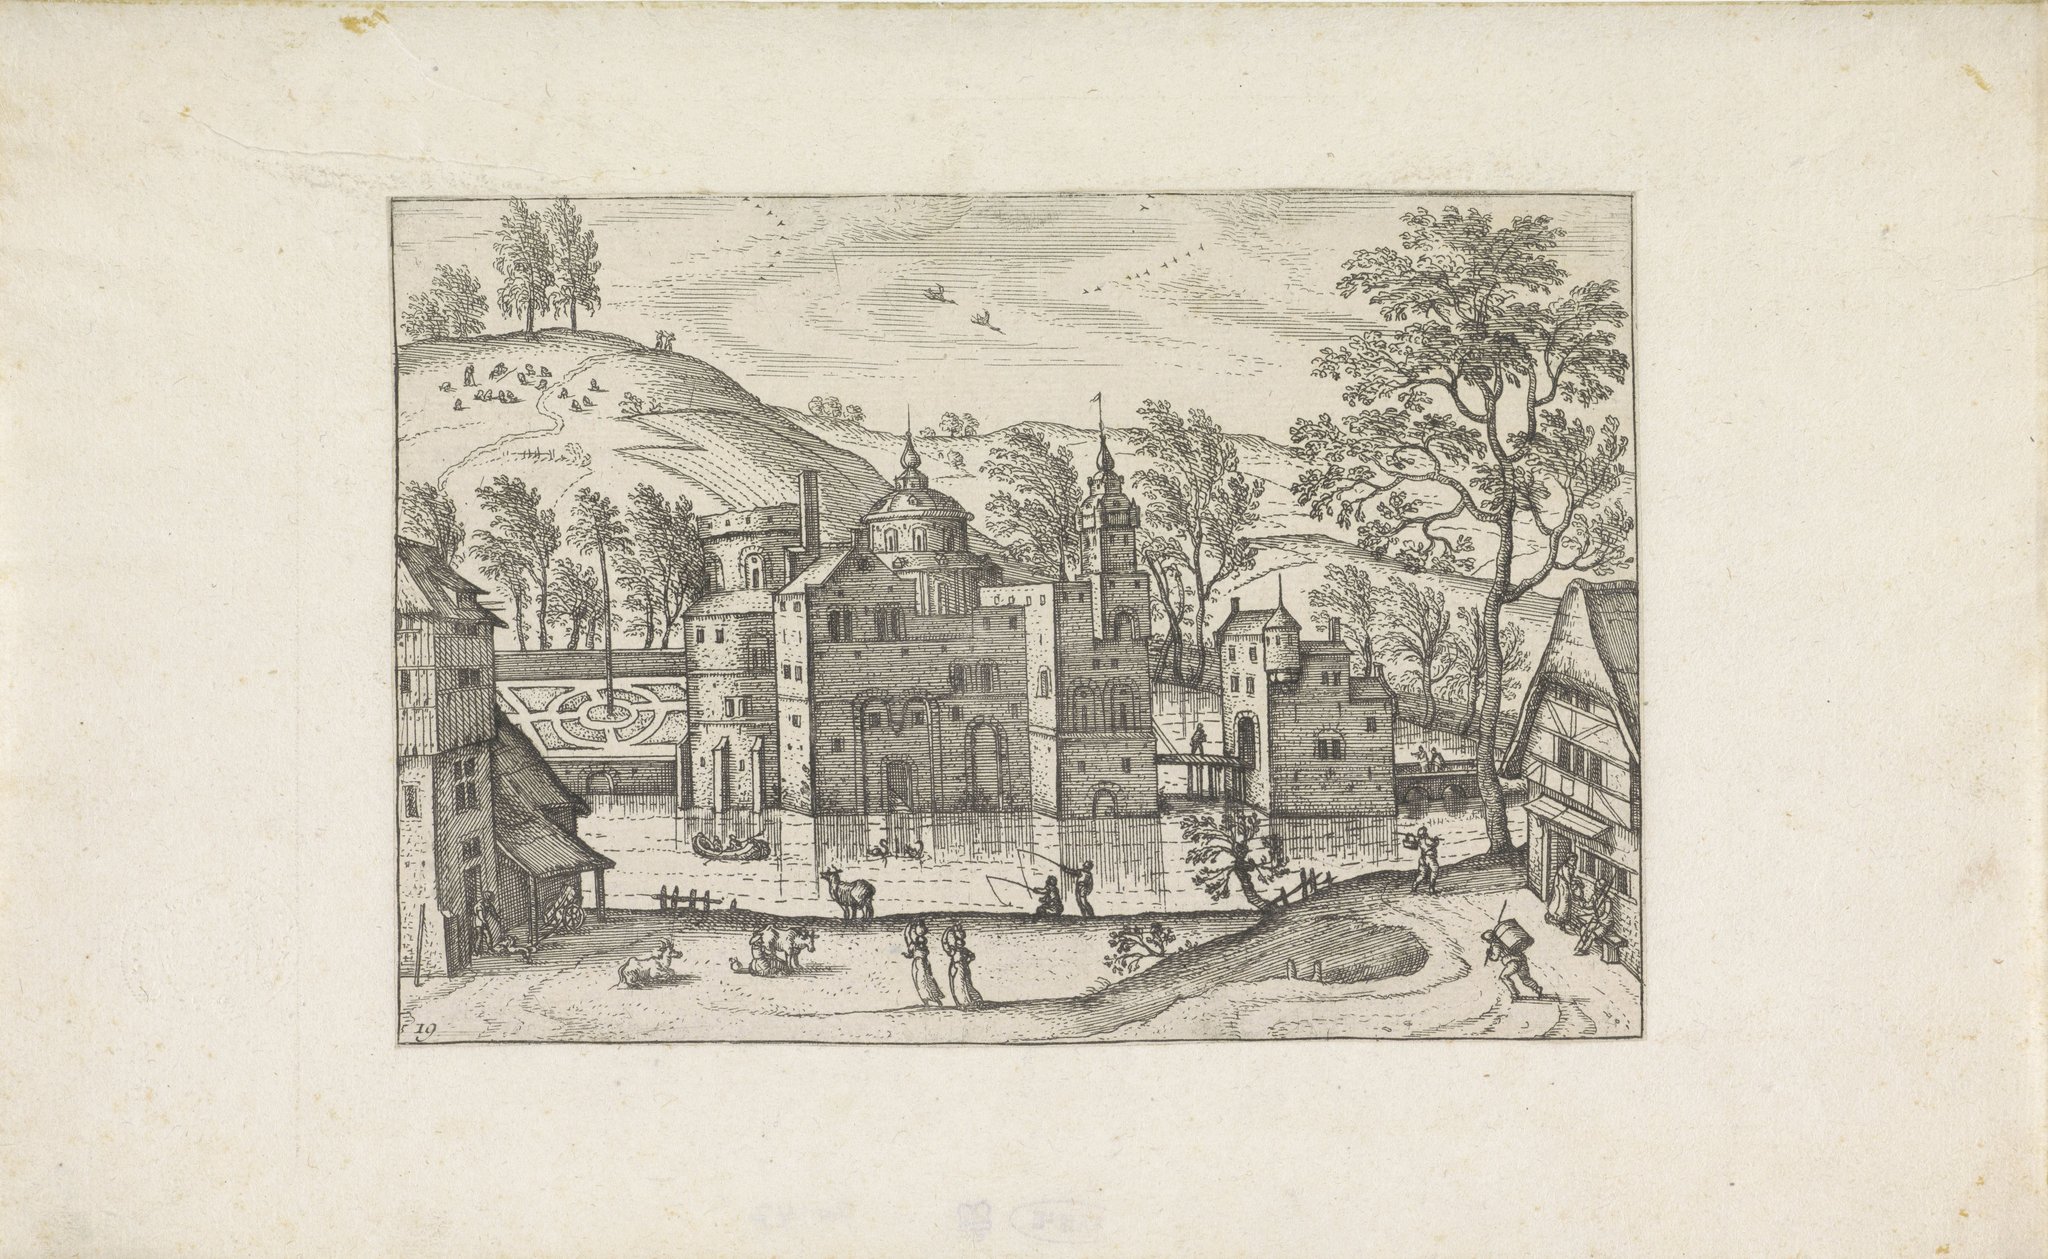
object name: print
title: Landschap met een door water omgeven kasteel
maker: pieter van der borcht (i)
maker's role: print maker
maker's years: 1545-1608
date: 1601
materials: paper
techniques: etching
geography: antwerp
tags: landscape with tower or castle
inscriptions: collector's mark: Lugt 2760, collector's mark: Lugt 4073, collector's mark: Lugt 2228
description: Deze prent is door uitgever Philips Galle toegevoegd aan de serie Kleine Landschappen, die door de gebroeders van Doetecum is gegraveerd naar ontwerp van de Meester van de Kleine Landschappen.